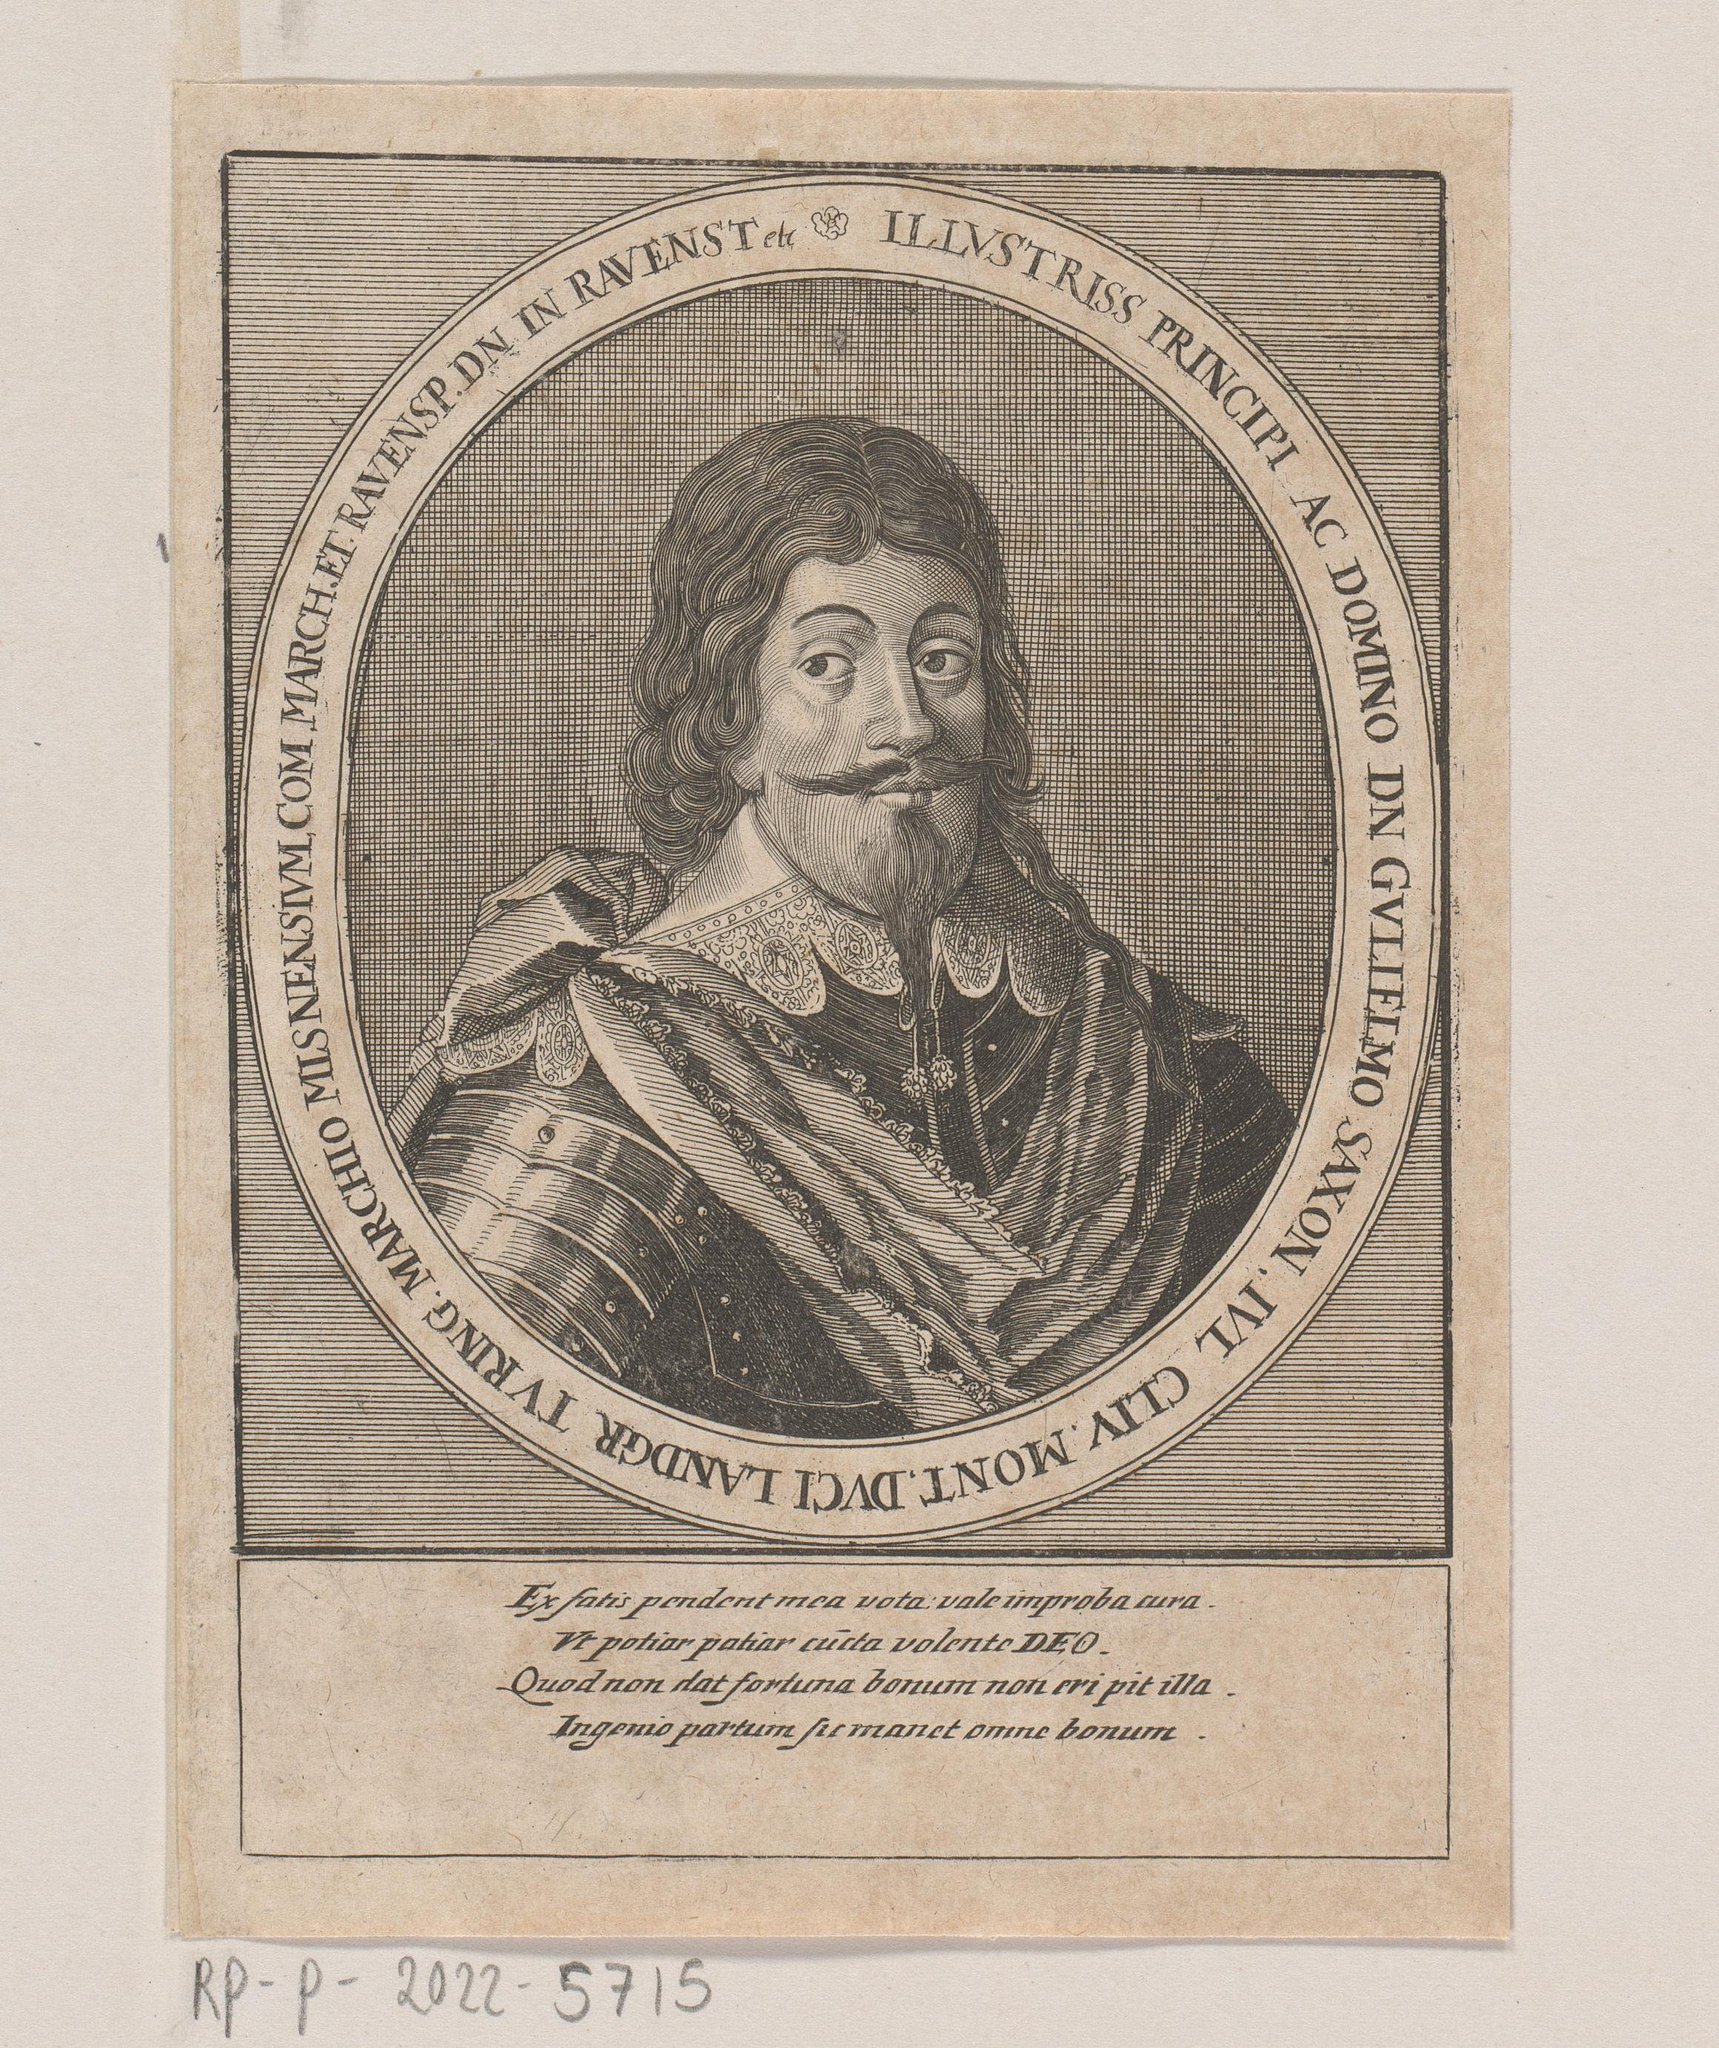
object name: book illustration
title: Portret van Willem van Saksen-Weimar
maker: Anonymous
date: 1630-1700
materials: paper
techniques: engraving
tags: historical persons